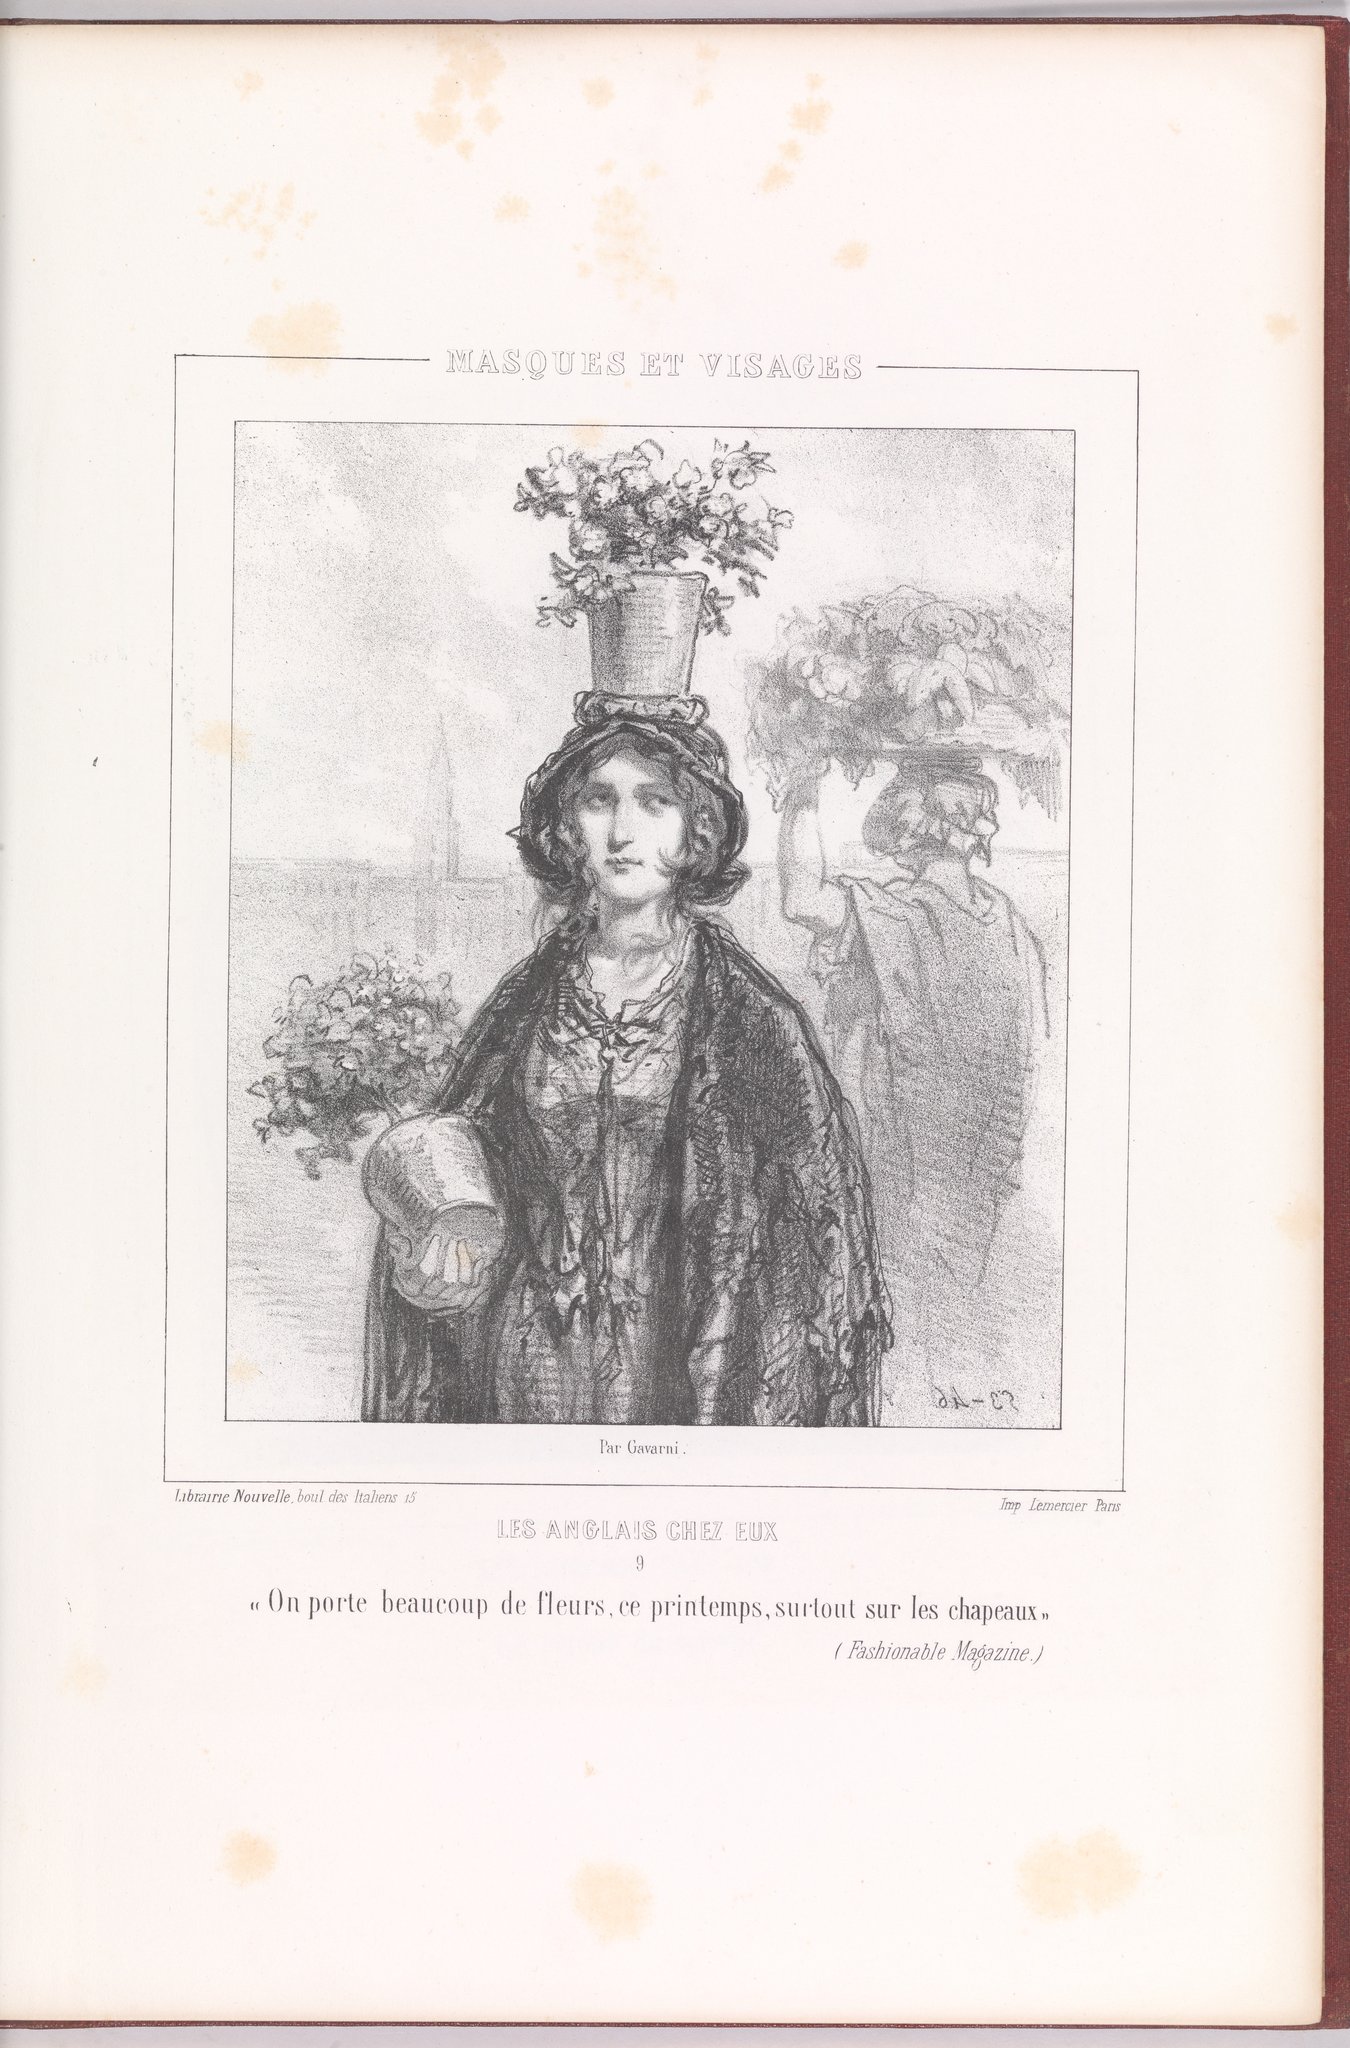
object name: print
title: "On porte beaucoup de fleurs, ce printemps, surtout sur les chapeaux", from Les Anglais Chez Eux, Masques et Visages, plate 9, bound in Oeuvres Nouvelles, vol. III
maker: paul gavarni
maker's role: artist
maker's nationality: french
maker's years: 1804-1866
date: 1853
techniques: lithograph